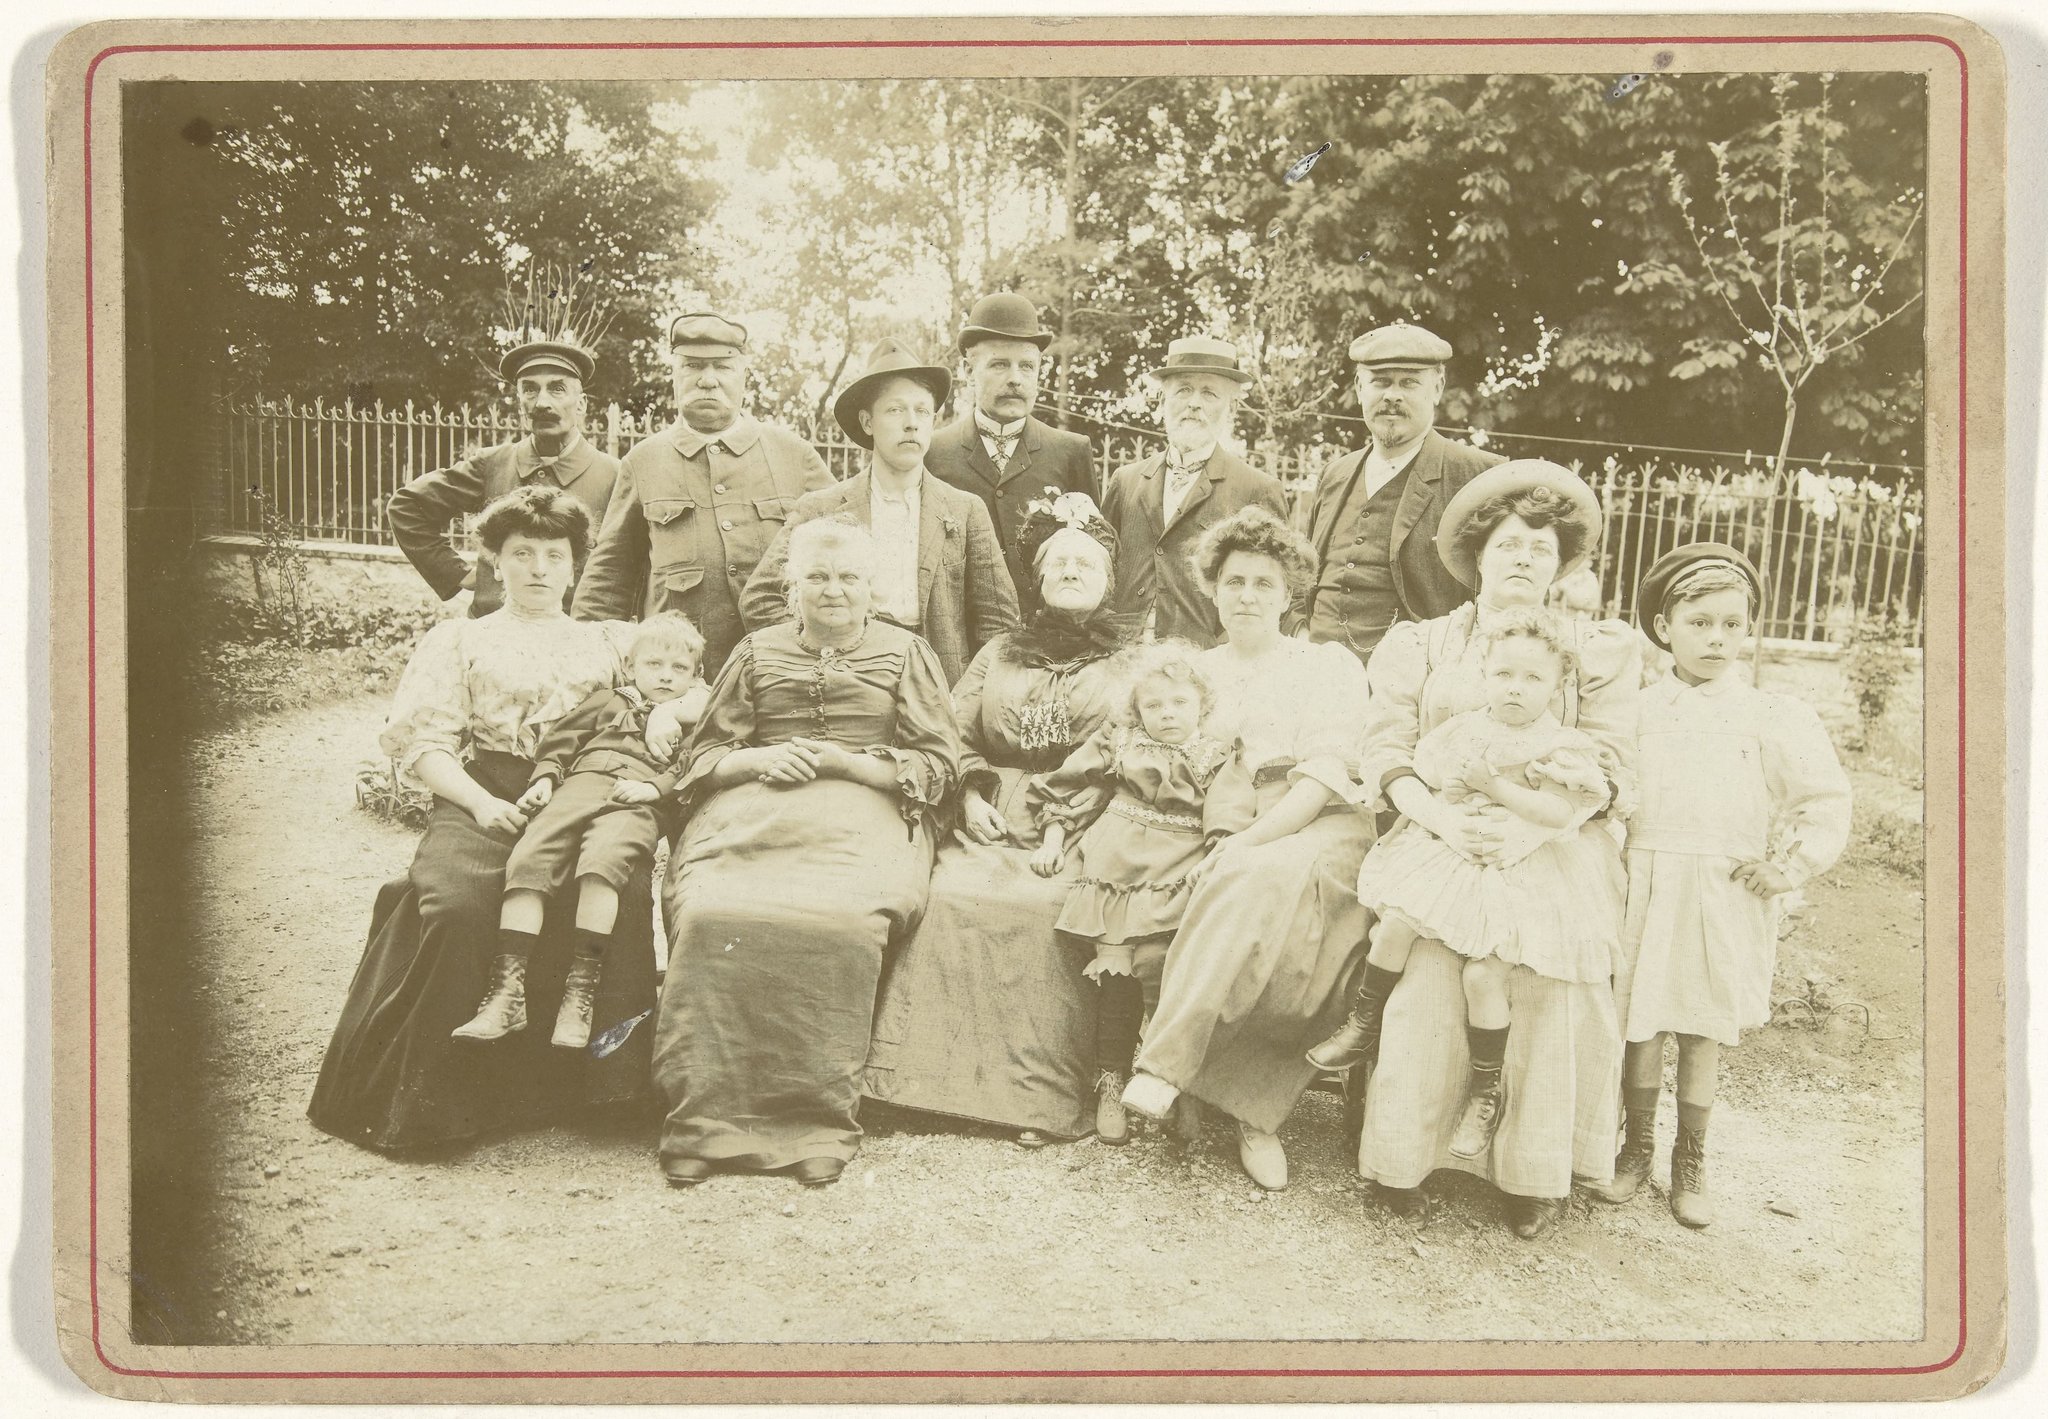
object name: cabinet photograph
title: Familieportret van onbekende leden van drie generaties in een tuin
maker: Anonymous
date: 1890-1910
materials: paper, cardboard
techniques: gelatin silver print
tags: three generations (family group), anonymous historical persons portrayed in a group, in a group-portrait